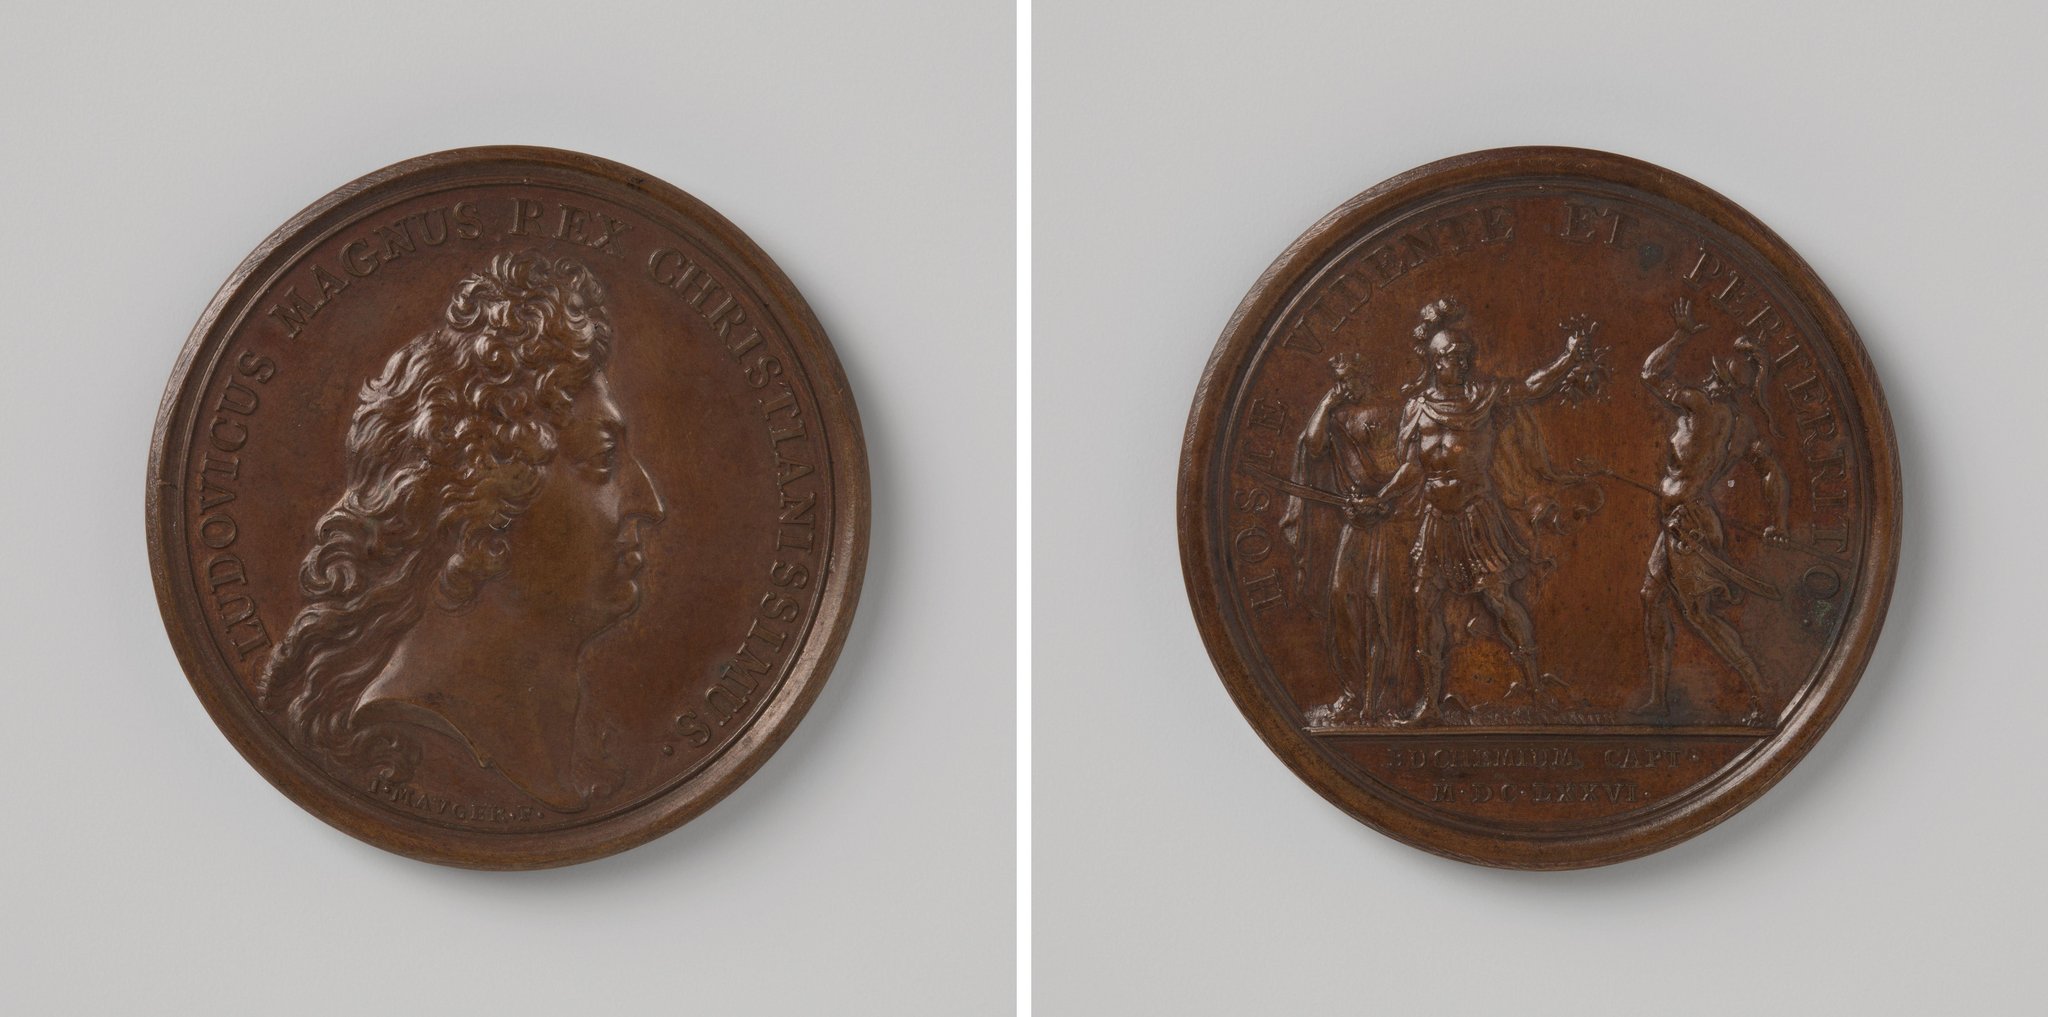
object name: history medal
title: Bouchain door de Fransen ingenomen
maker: jean mauger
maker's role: medailleur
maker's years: 1648-1722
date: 1699-1703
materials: bronze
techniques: striking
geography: paris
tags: lodewijk xiv (koning van frankrijk)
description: Bronzen penning. Voorzijde: borststuk man binnen omschrift. Keerzijde: de Franse koning toont aan naderende krijger, voorstellende het Nederlandse leger het afgesneden hoofd van Medusa; daarnaast gekroonde vrouw, voorstellende Bouchain binnen omschrift.